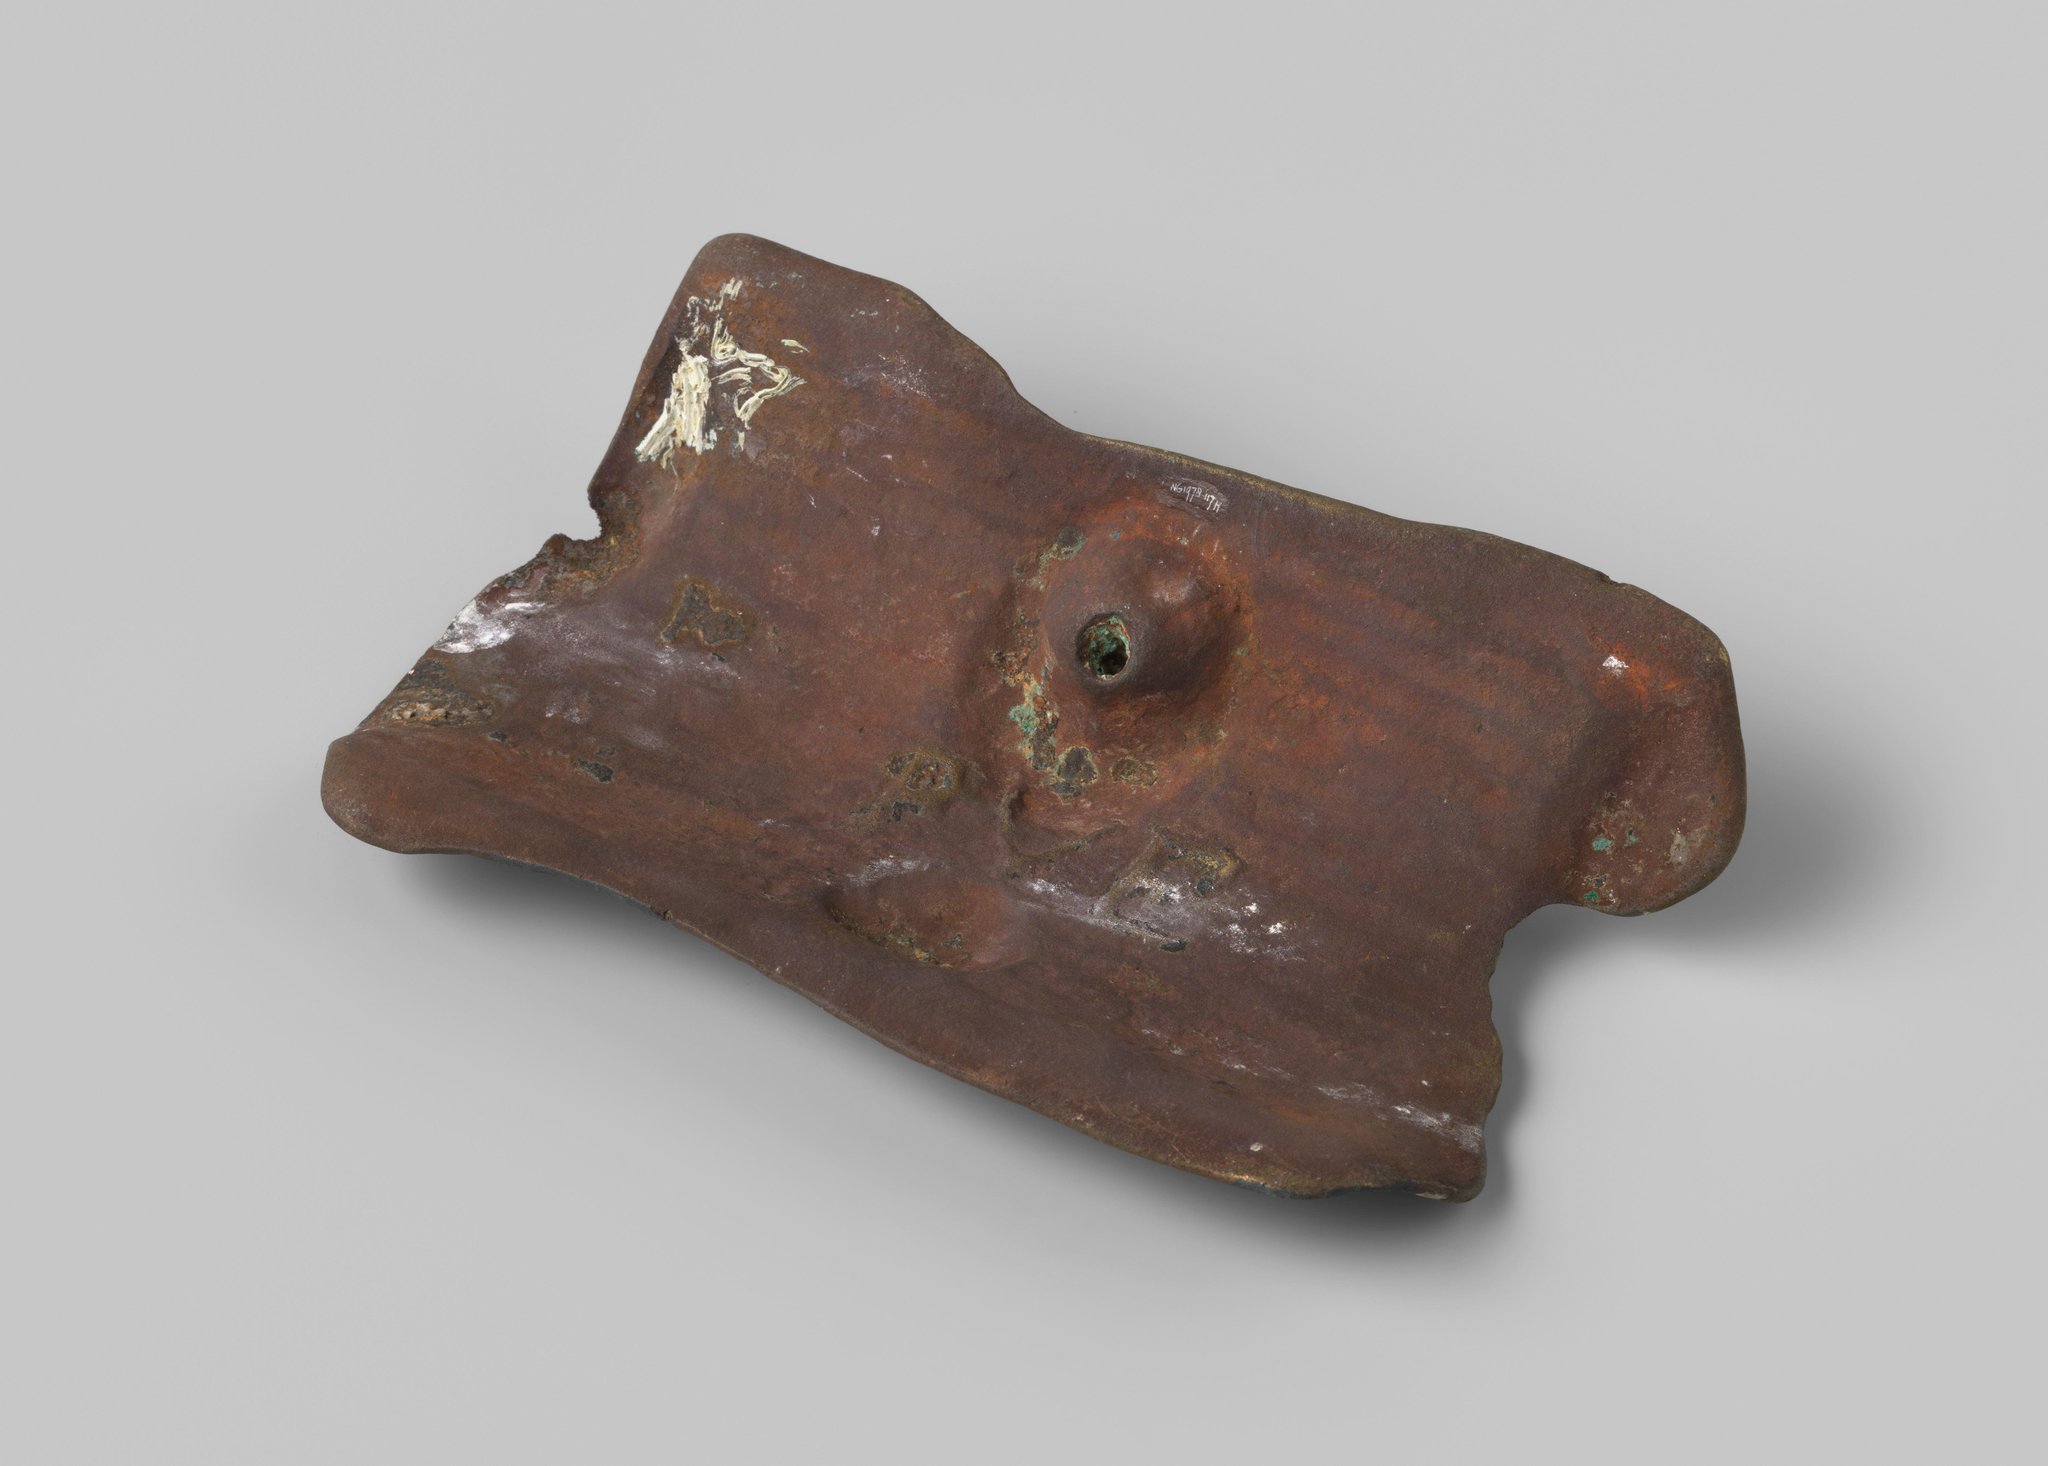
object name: flask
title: Gietmal uit het wrak van de Oost-Indiëvaarder Hollandia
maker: Anonymous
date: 1700-1743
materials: copper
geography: netherlands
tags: verenigde oostindische compagnie, hollandia (schip), annet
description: Tools and instruments, lead casting, mould; countermould, eroded: oblong with straight sides, curved, relieved cast design on convex side, eroded (large central boss), on the reverse handle fitting and inscription NG-1979-192-H-3074.